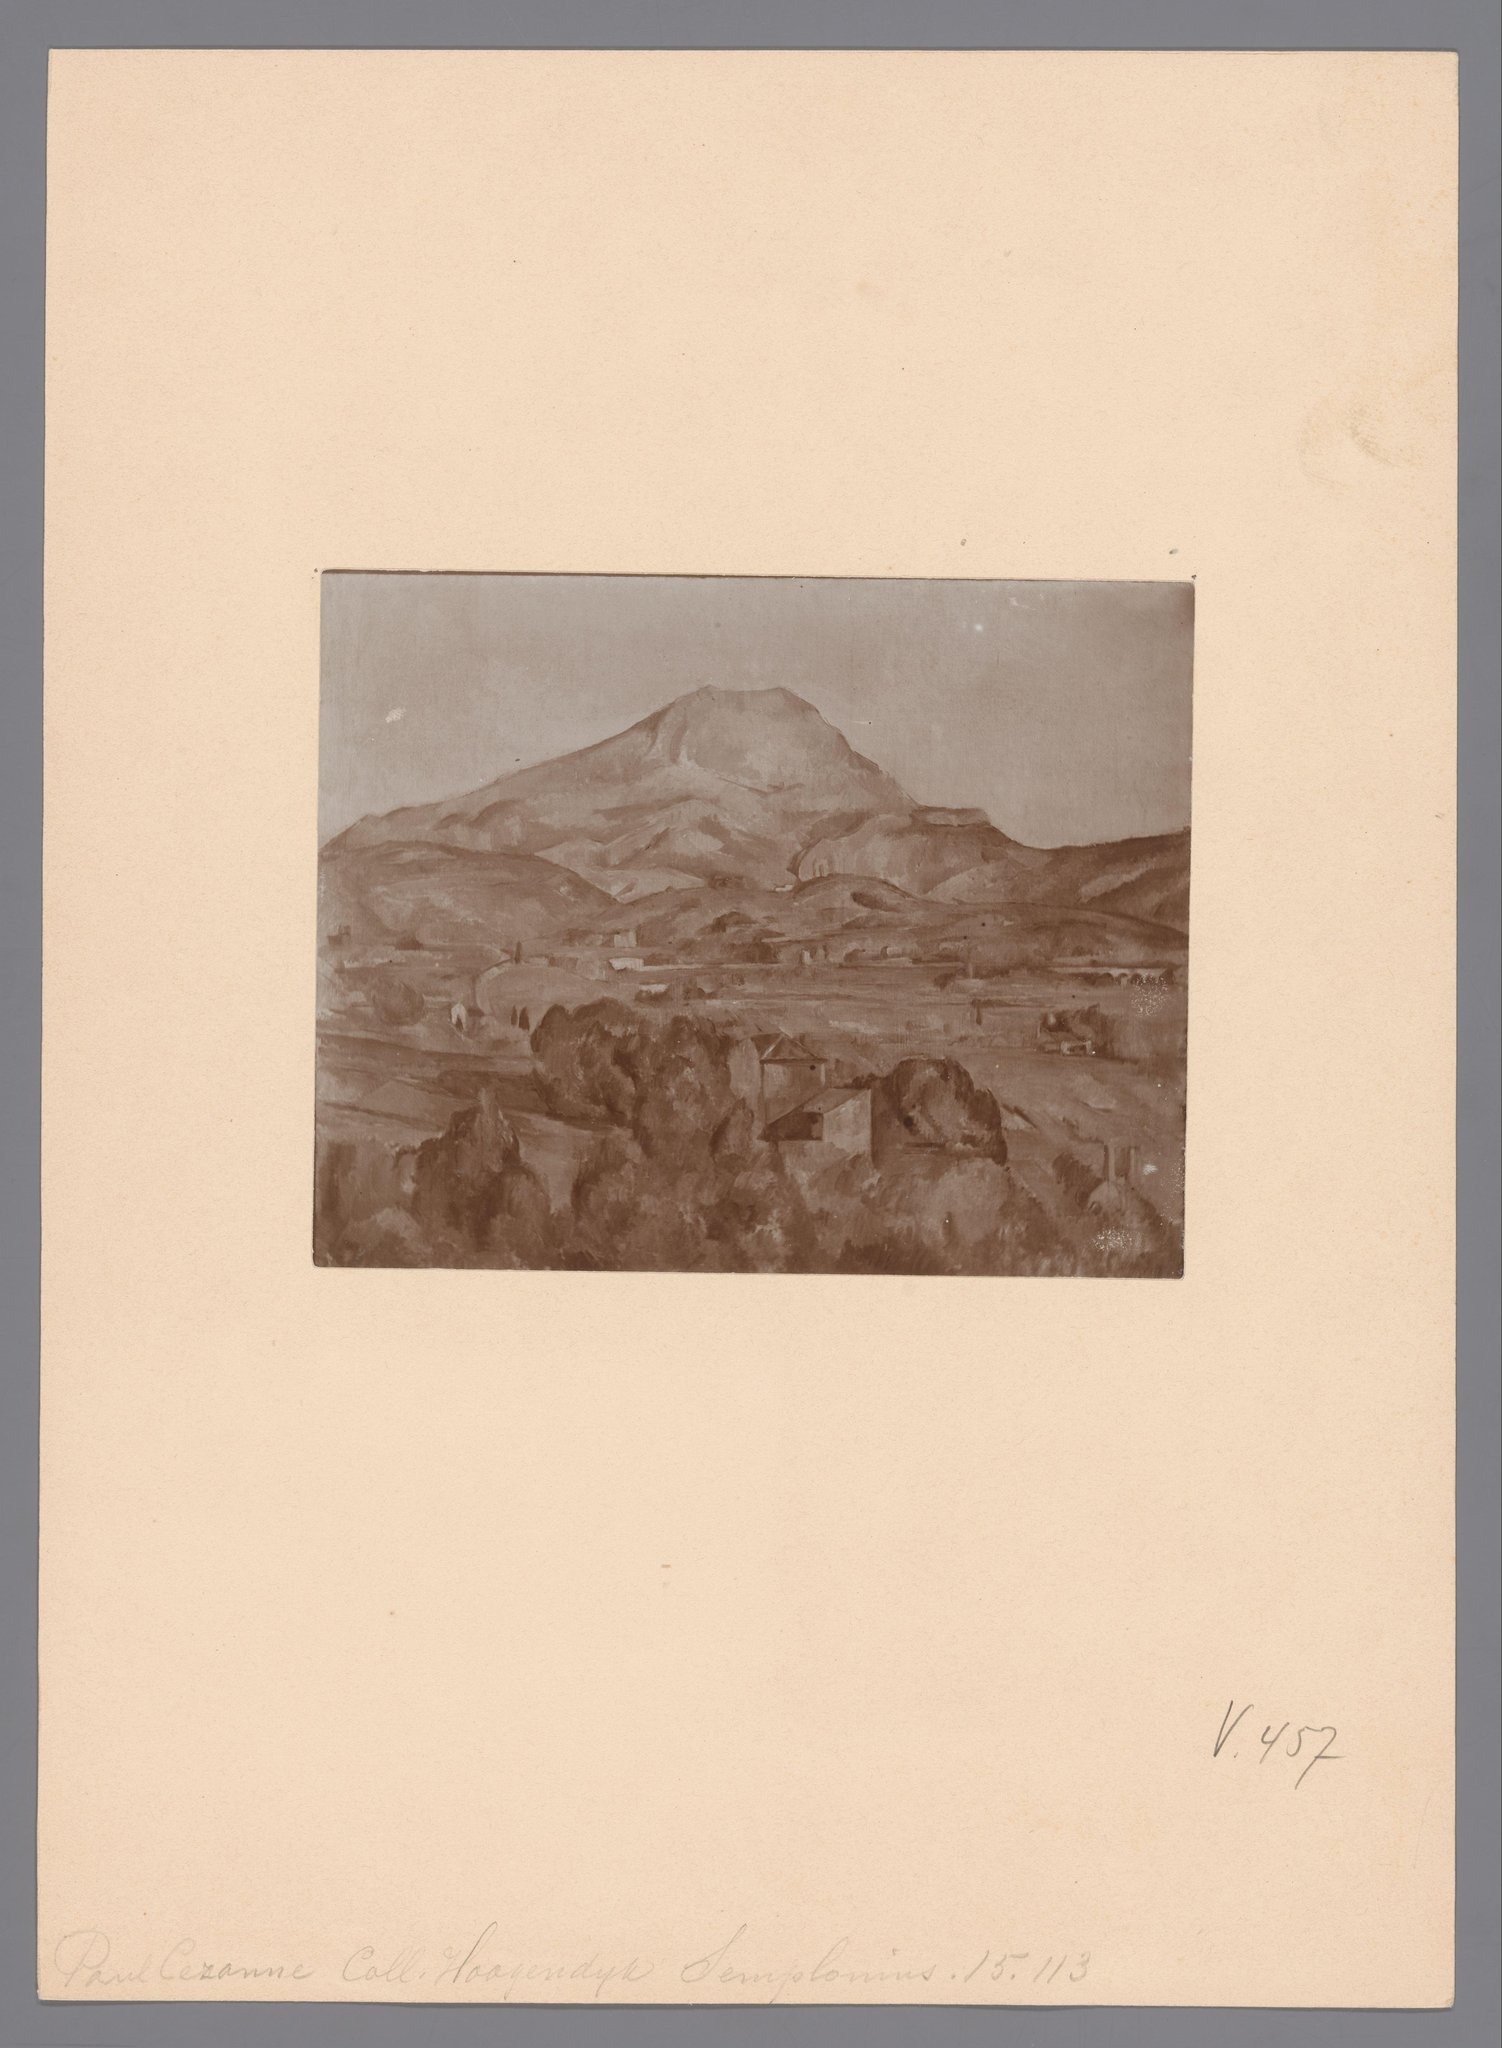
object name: photograph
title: Fotoreproductie van een schilderij met een gezicht op de Mont Sainte-Victoire bij Aix-en-Provence door Paul Cézanne uit de collectie Hoogendijk, nu in The Barnes Foundation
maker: koop remmerts semplonius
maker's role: draughtsman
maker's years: 1847-1915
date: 1915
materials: paper, cardboard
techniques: collodion silver print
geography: the hague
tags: picture, painting, mountains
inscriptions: inscription: ‘Paul Cezanne Coll. Hoogendijk Semplonius. 15.113’, inscription: ‘V. 457’, collector's mark: Lugt 2228, inscription: ‘15.113.’